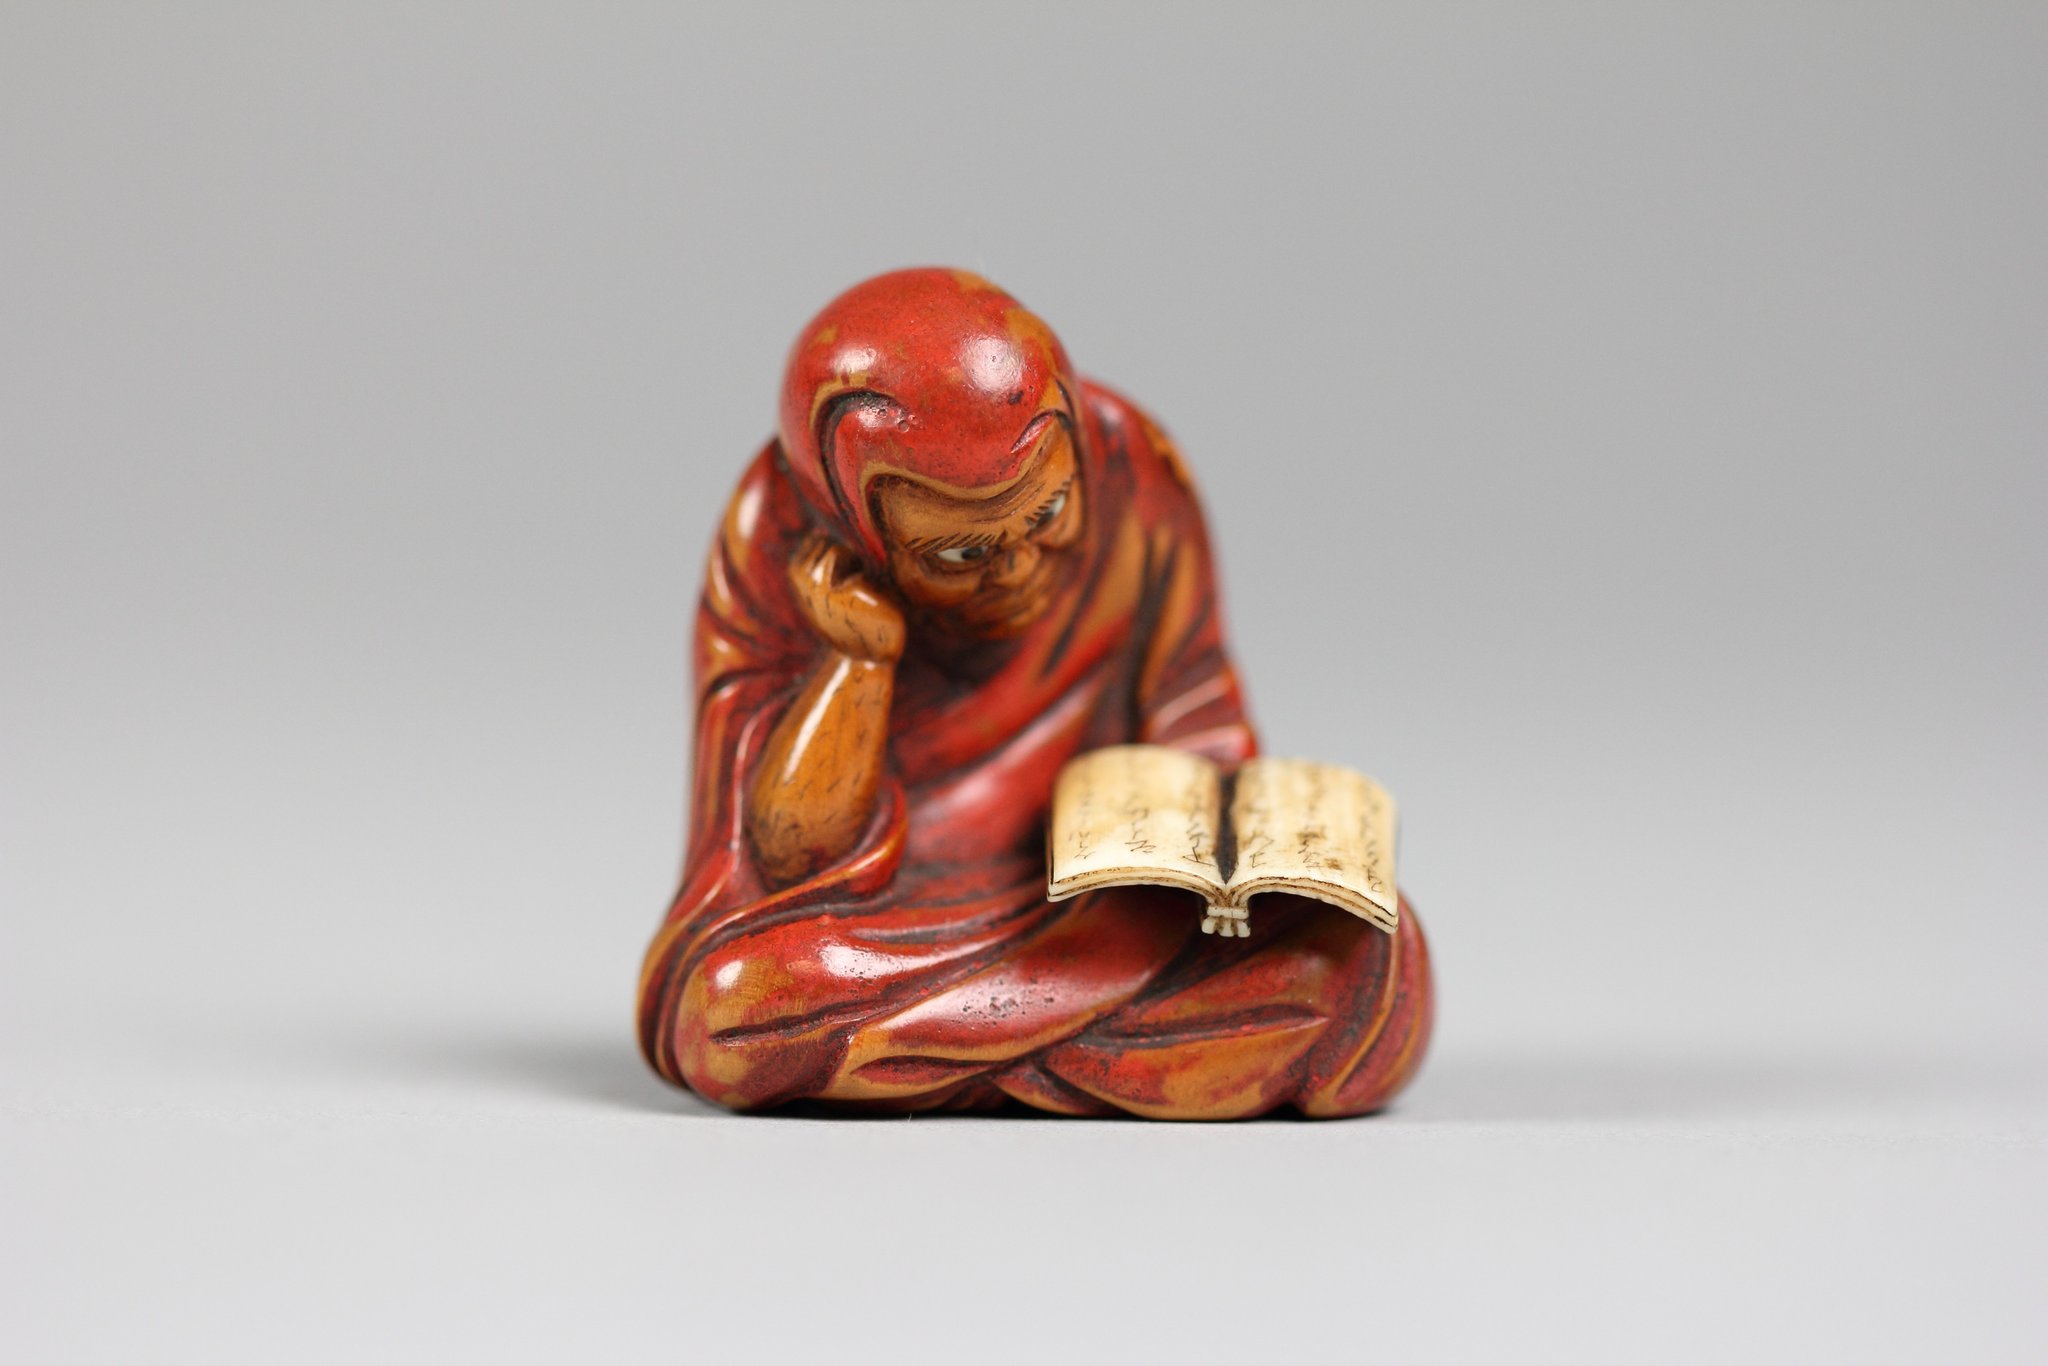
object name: netsuke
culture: japanese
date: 1801-1900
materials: lacquer, wood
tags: human figures